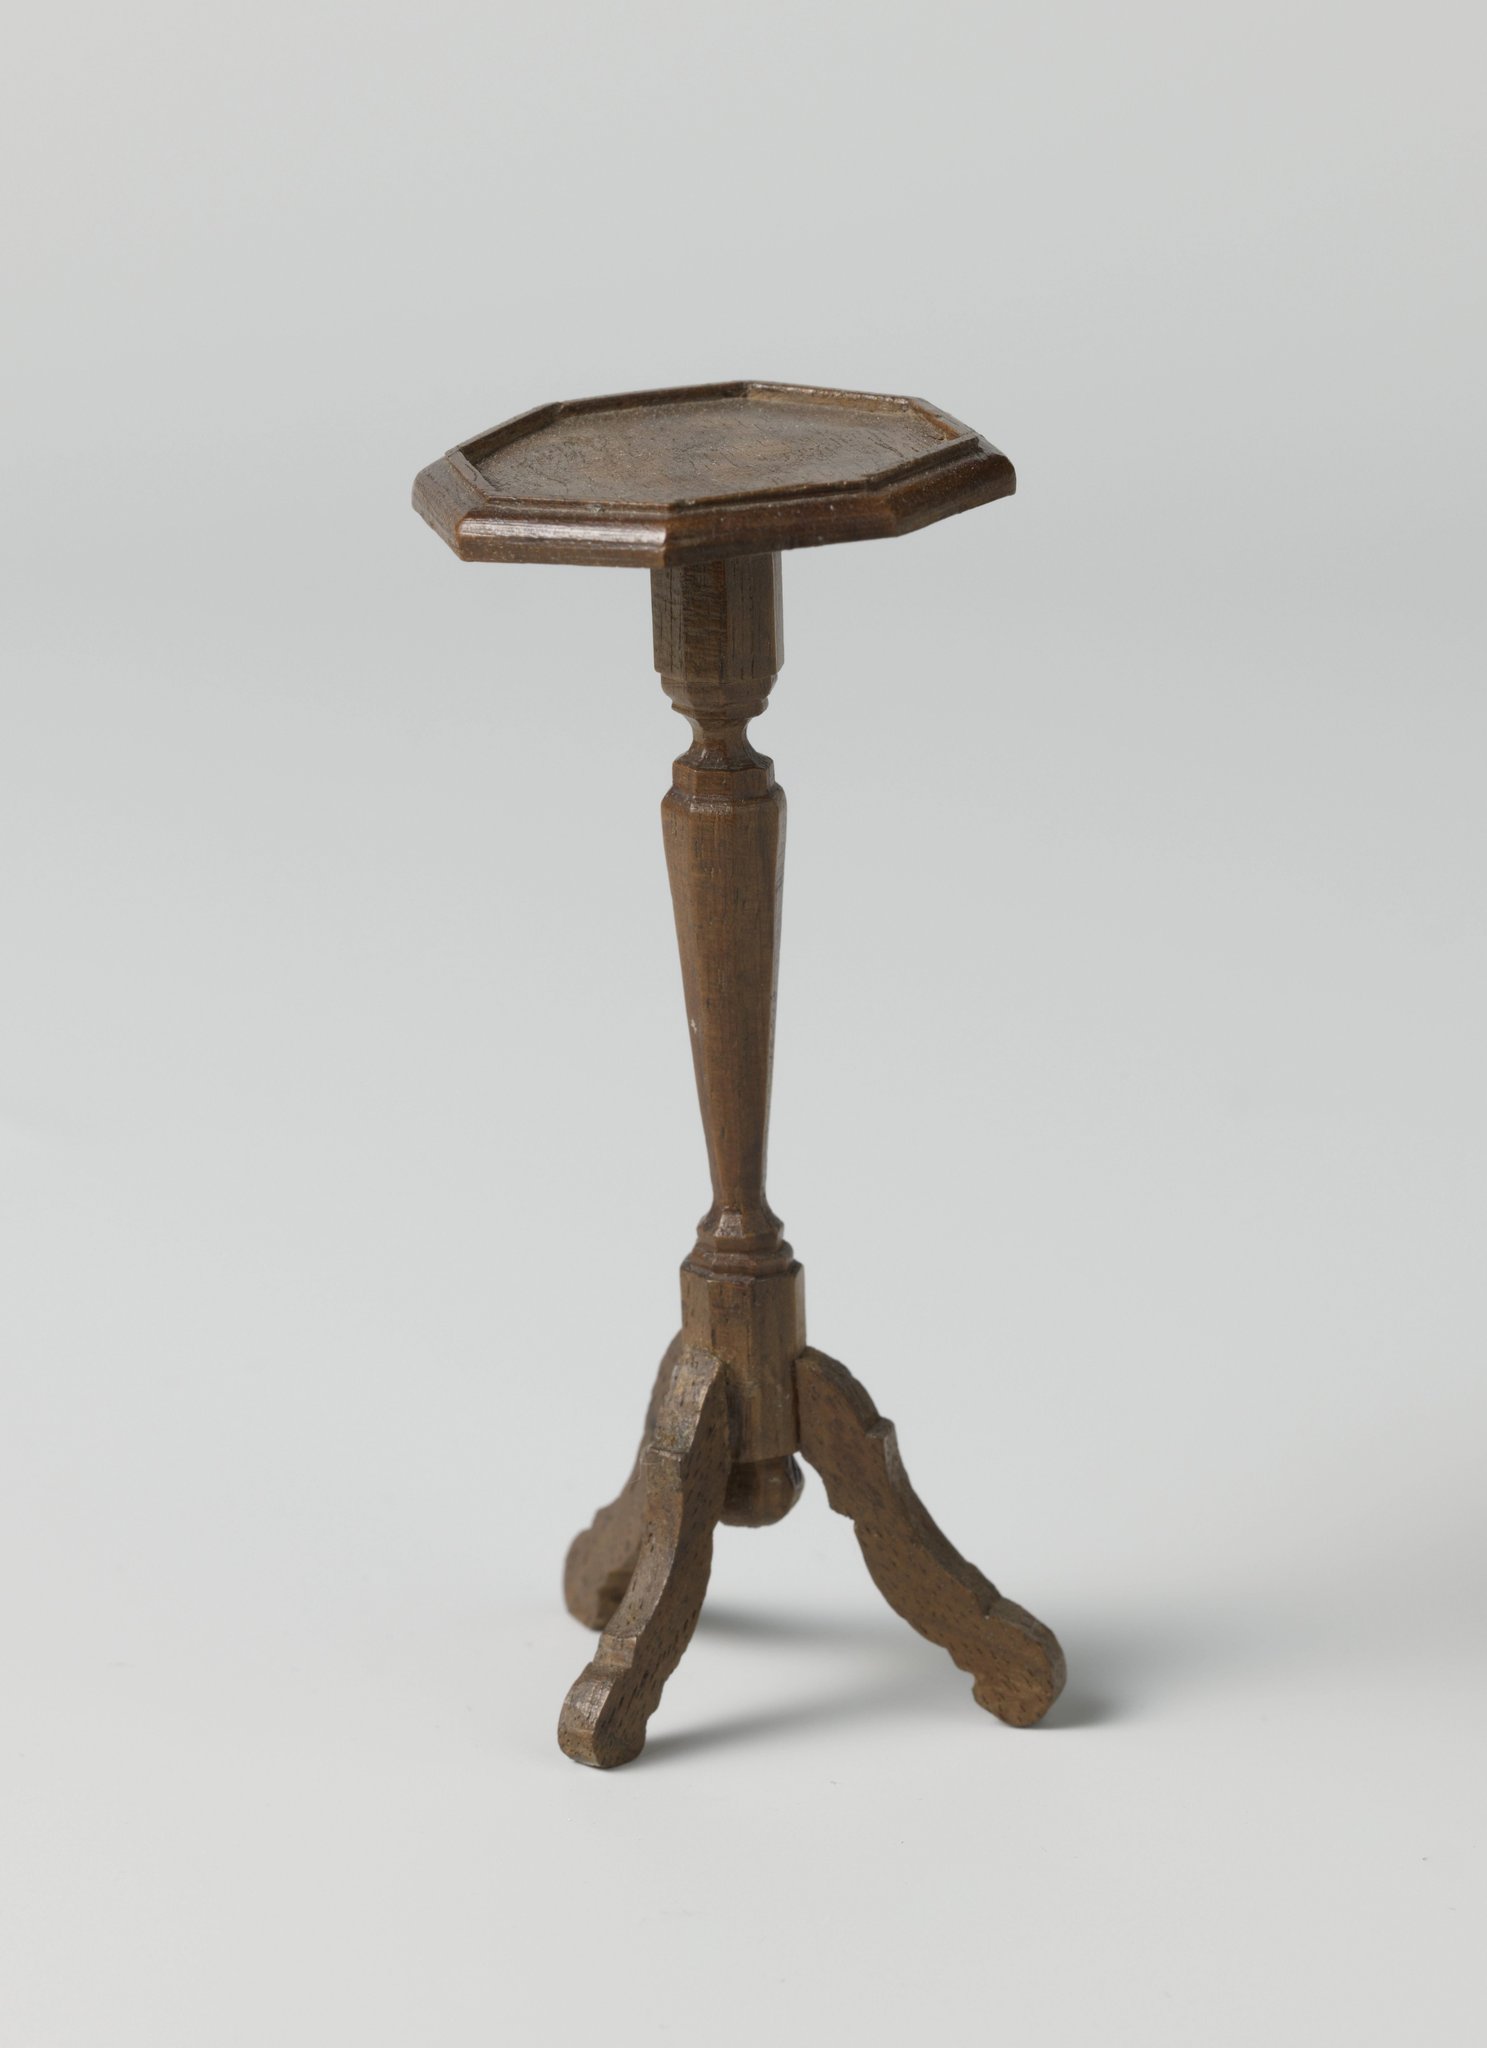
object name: miniature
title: Gueridon met achthoekig blad, op taps toelopende, geprofileerde stam op drie s-vormige poten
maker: Anonymous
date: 1750-1800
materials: wood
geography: amsterdam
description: Gueridon van notenhout, met achthoekig blad met opstaande rand, op taps toelopende, geprofileerde stam op drie s-vormige poten.